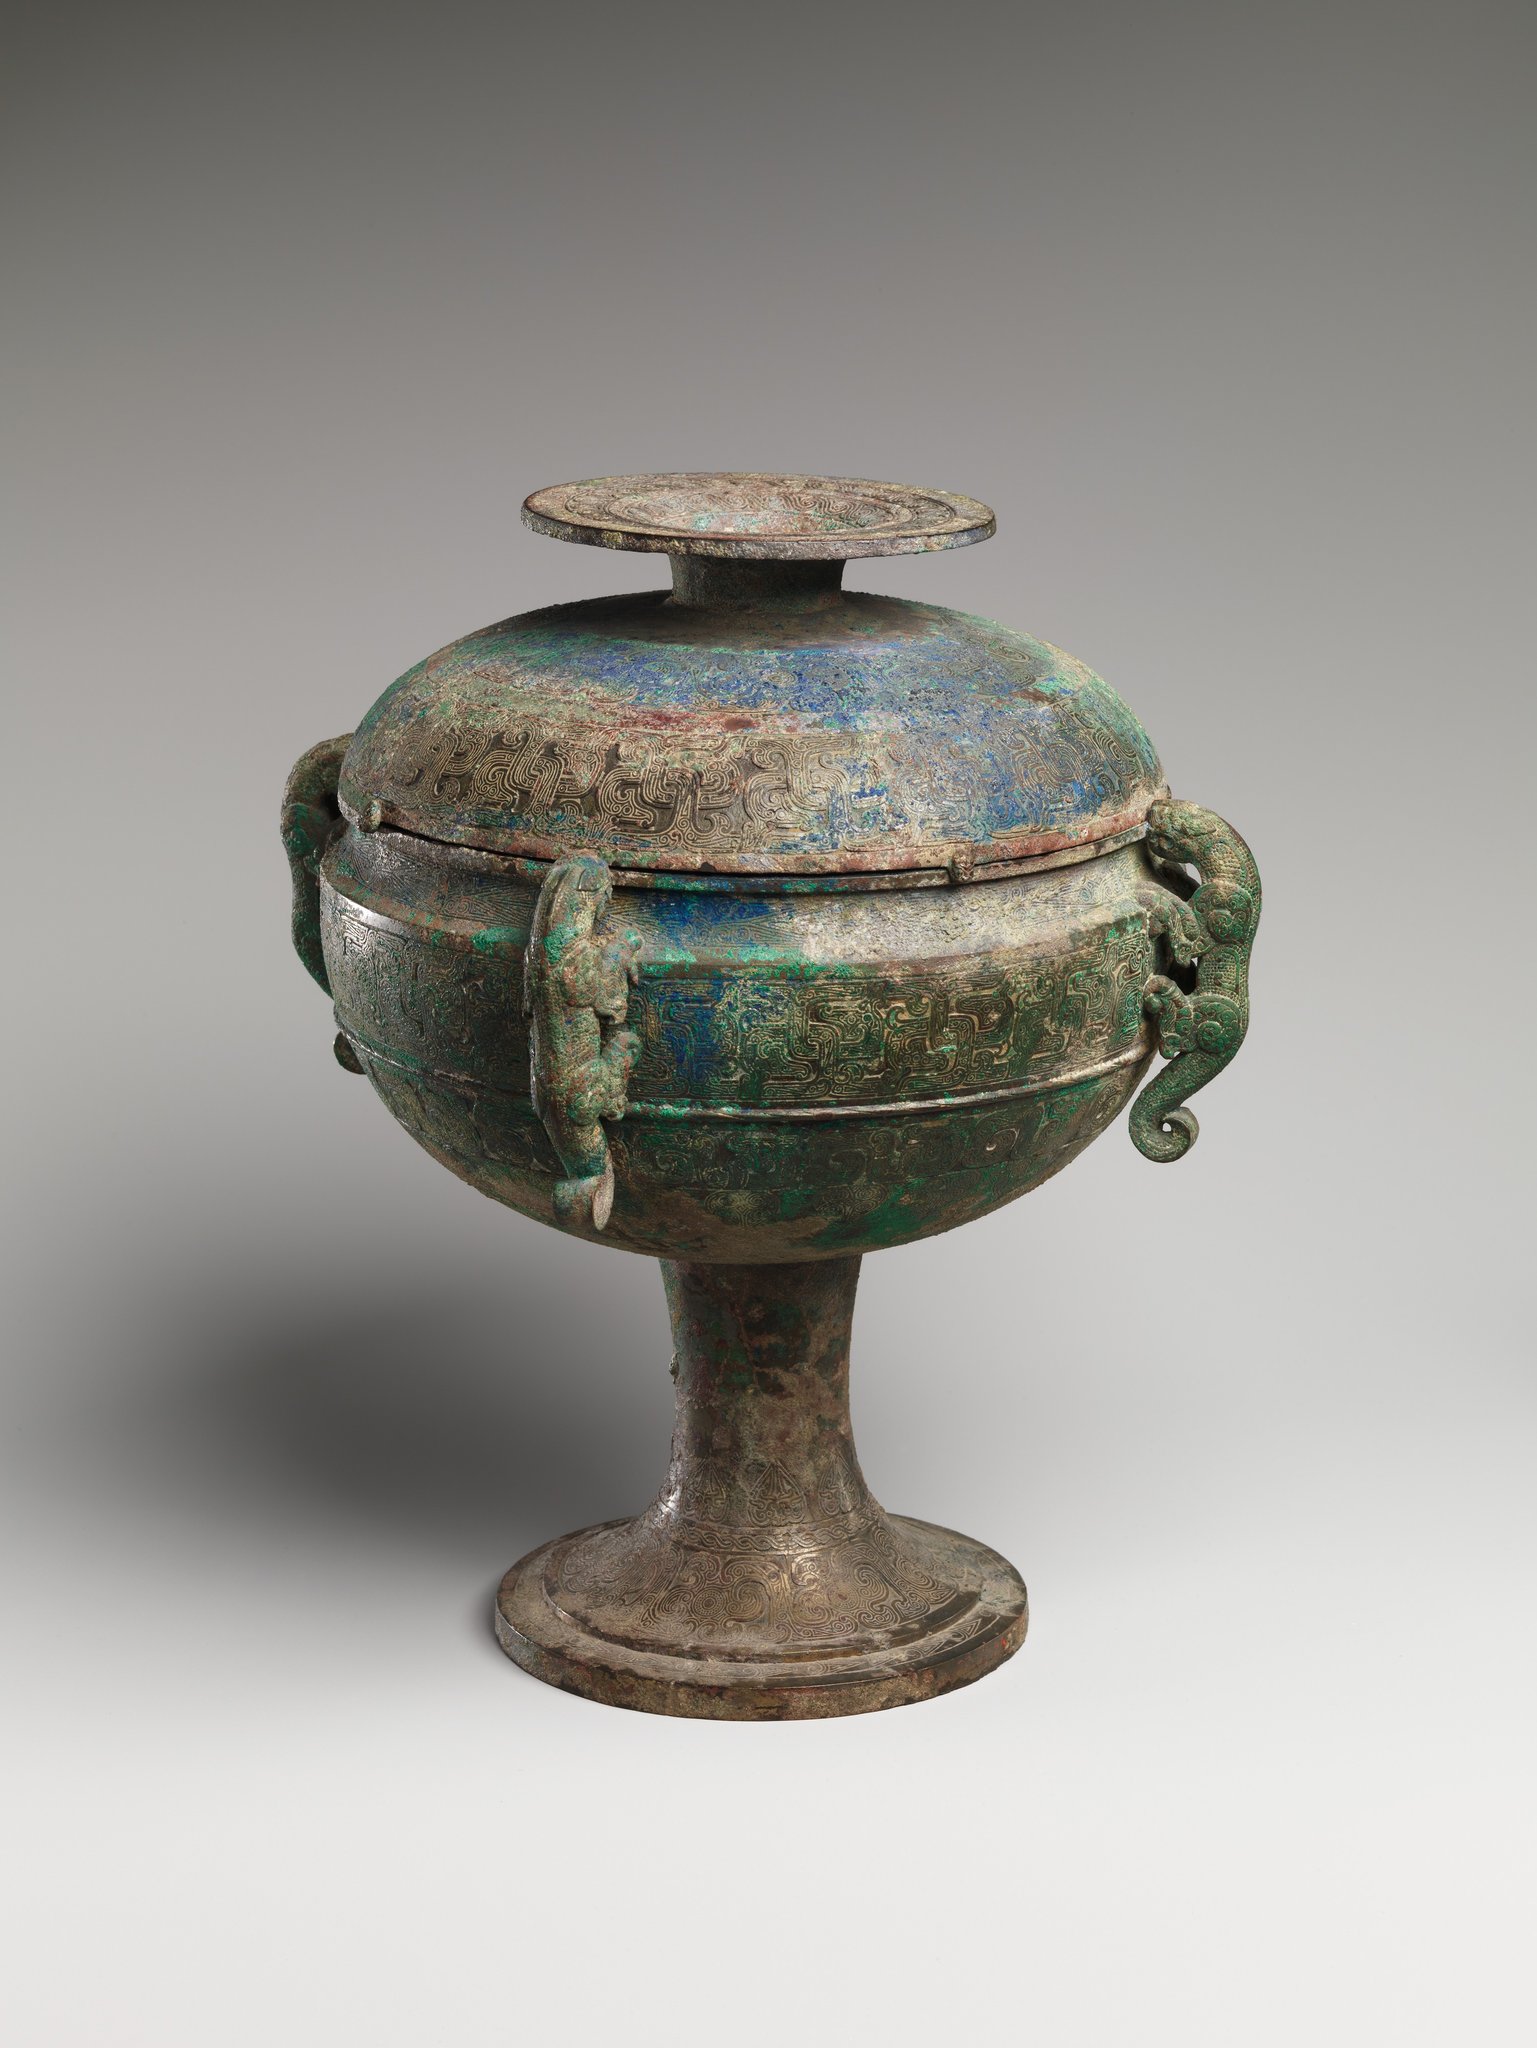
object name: food vessel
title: Food serving vessel (dou)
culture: chinese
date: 534-468 BCE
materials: bronze